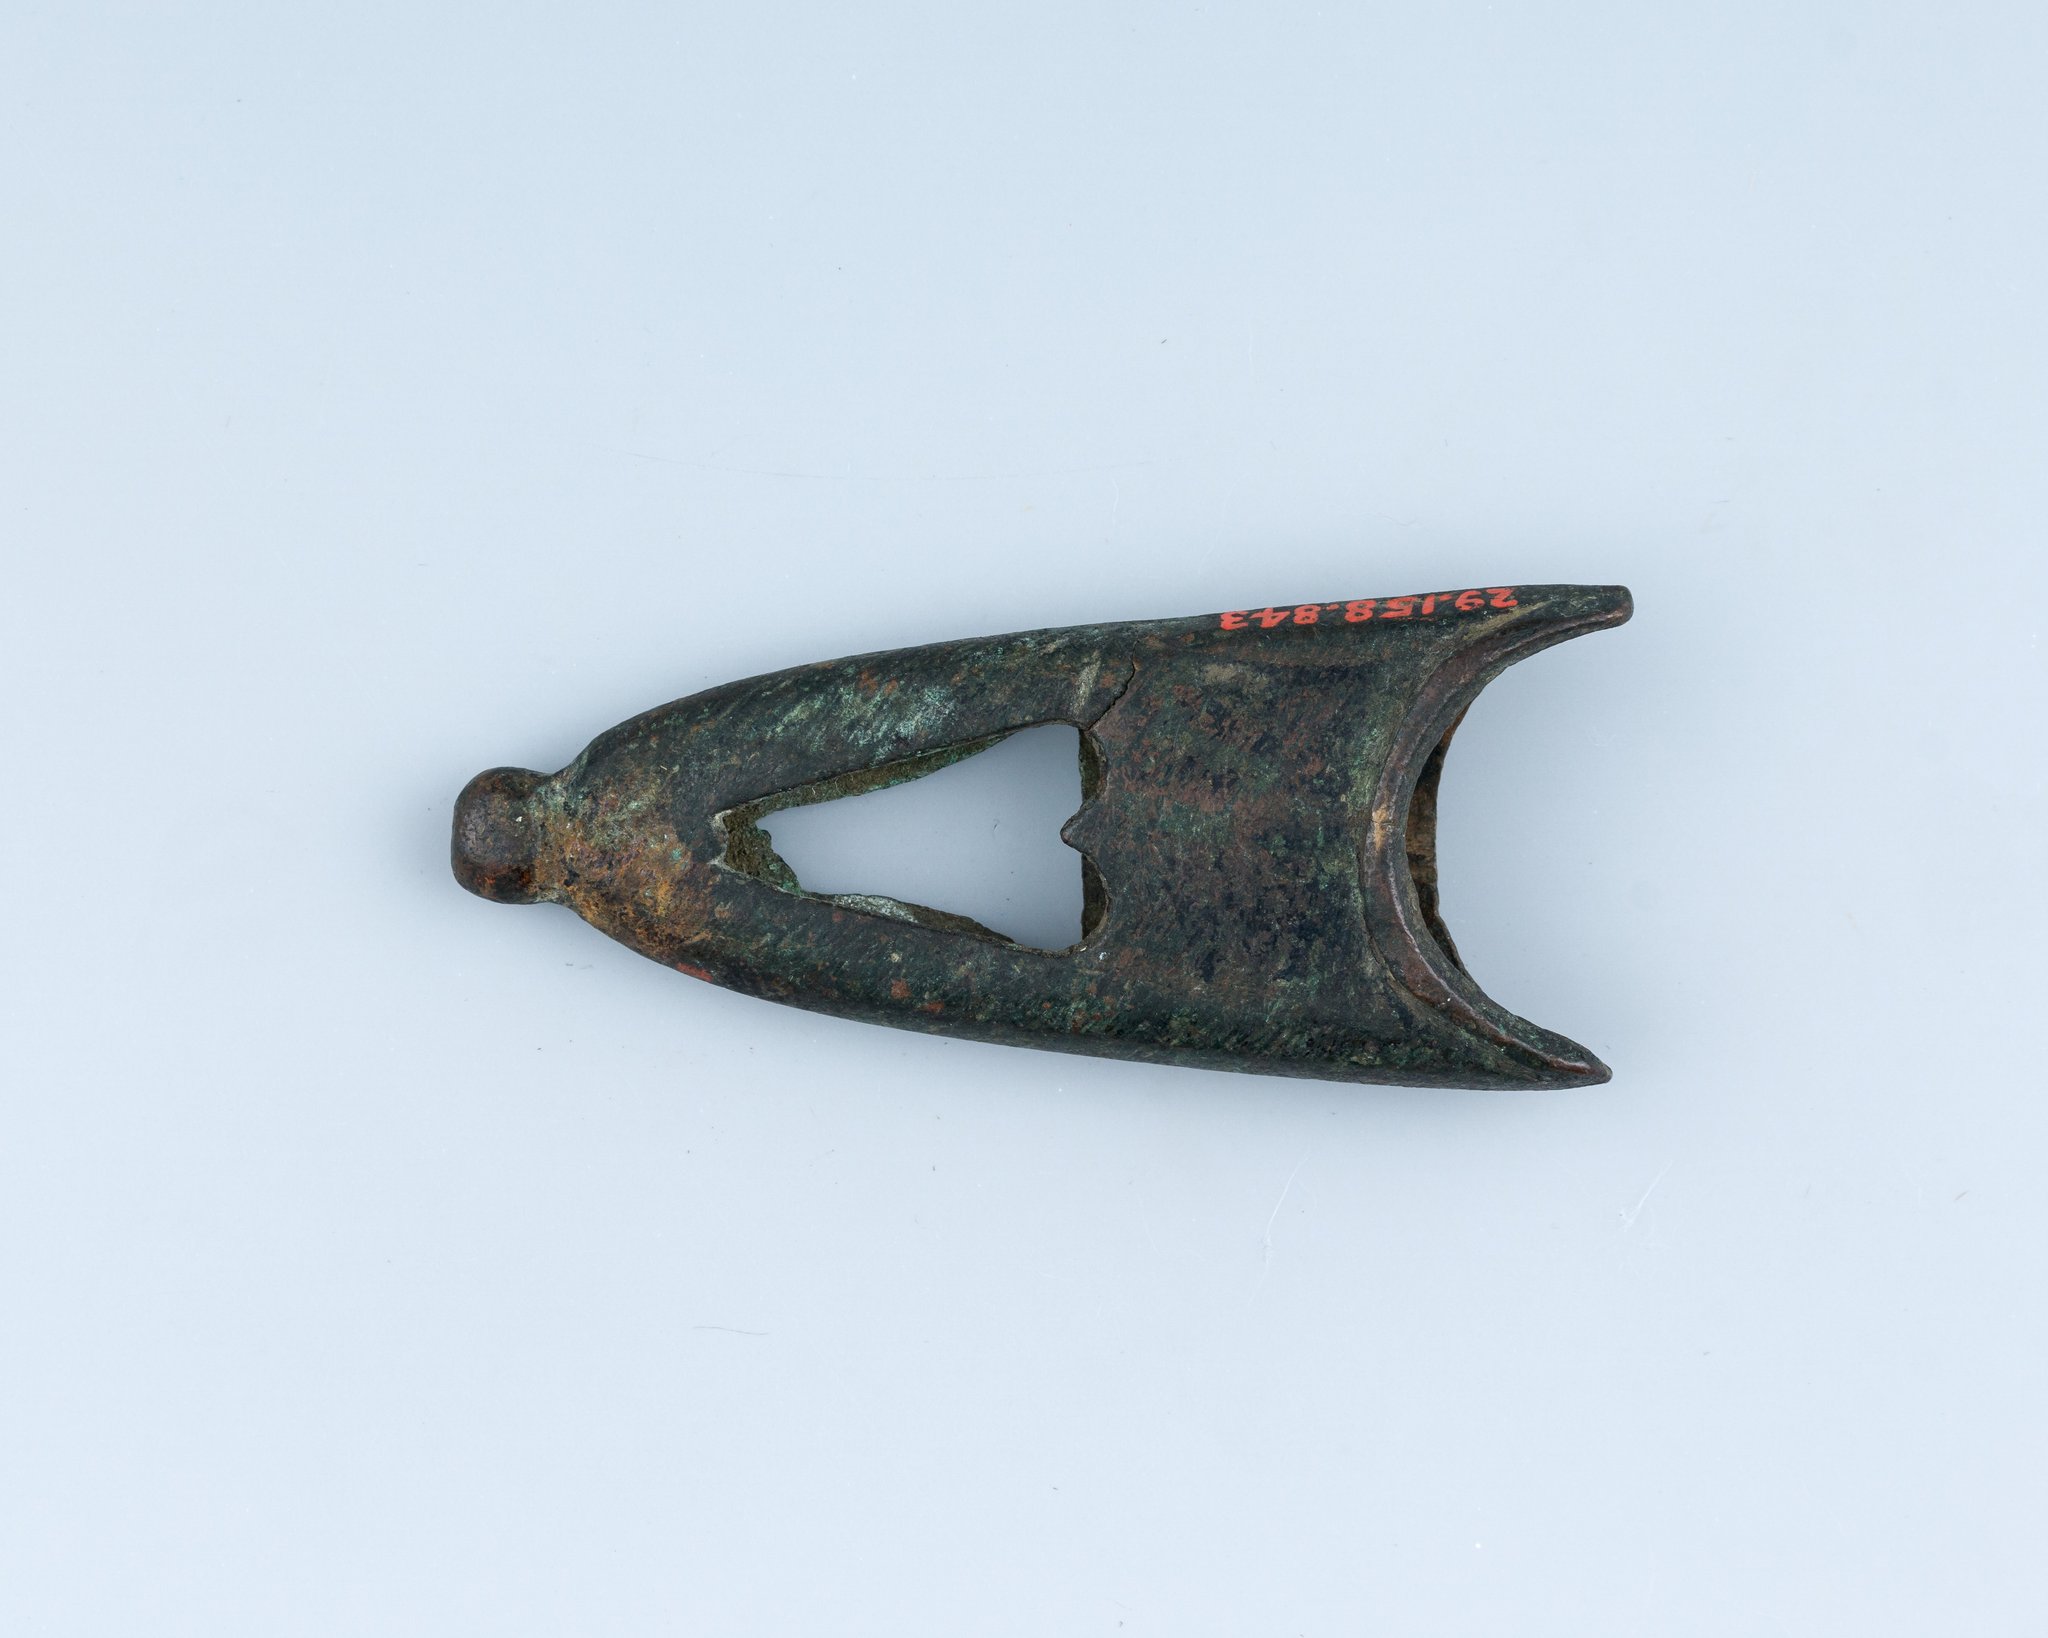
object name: mordant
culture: european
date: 1401-1700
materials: bronze